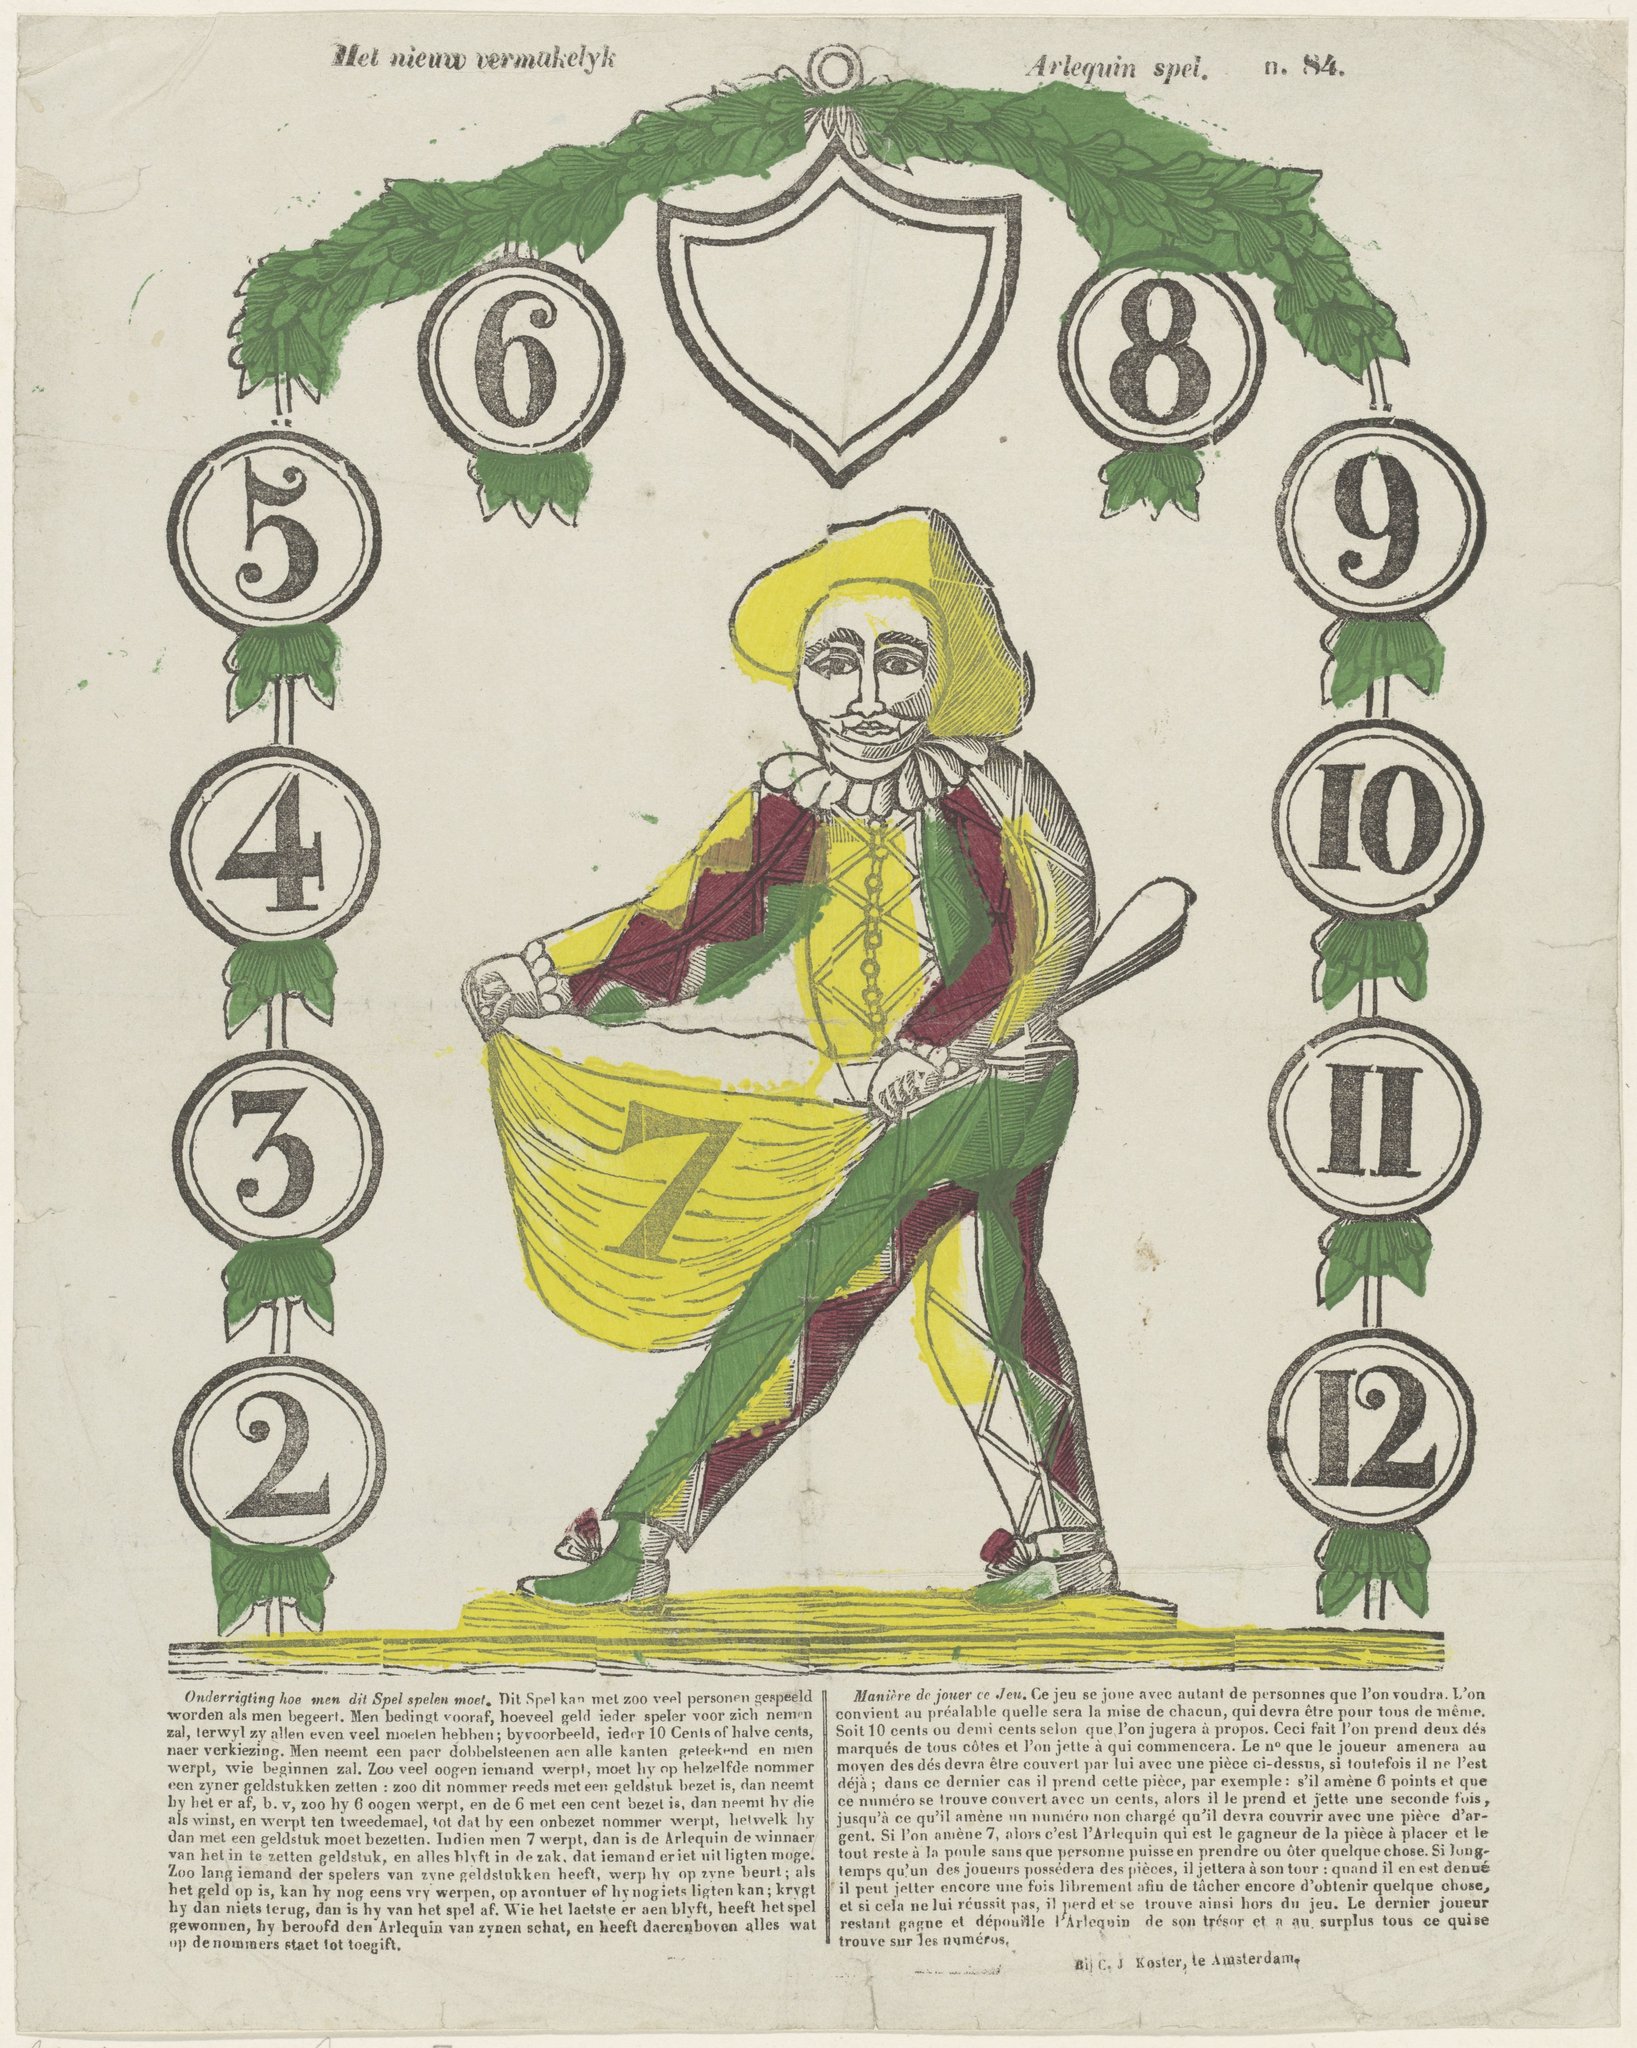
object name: gameboard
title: Het nieuw vermakelyk Arlequin spel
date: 1833-1847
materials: paper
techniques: colour, letterpress printing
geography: turnhout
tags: board-games of chance, types in 'commedia dell'arte': harlequin, board-games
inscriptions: collector's mark: Lugt 2760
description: Bordspel met in het midden van het speelveld een harlekijn die in zijn geopende handen een zak houdt met daarop het cijfer 7. Rondom hem een guirlande waaraan medaillons hangen met de cijfers 2 tot en met 12. Bovenaan in het midden een schild. Onder de voorstelling de spelregels in het Nederlands en in het Frans in twee kolommen. Genummerd rechtsboven: n. 84.